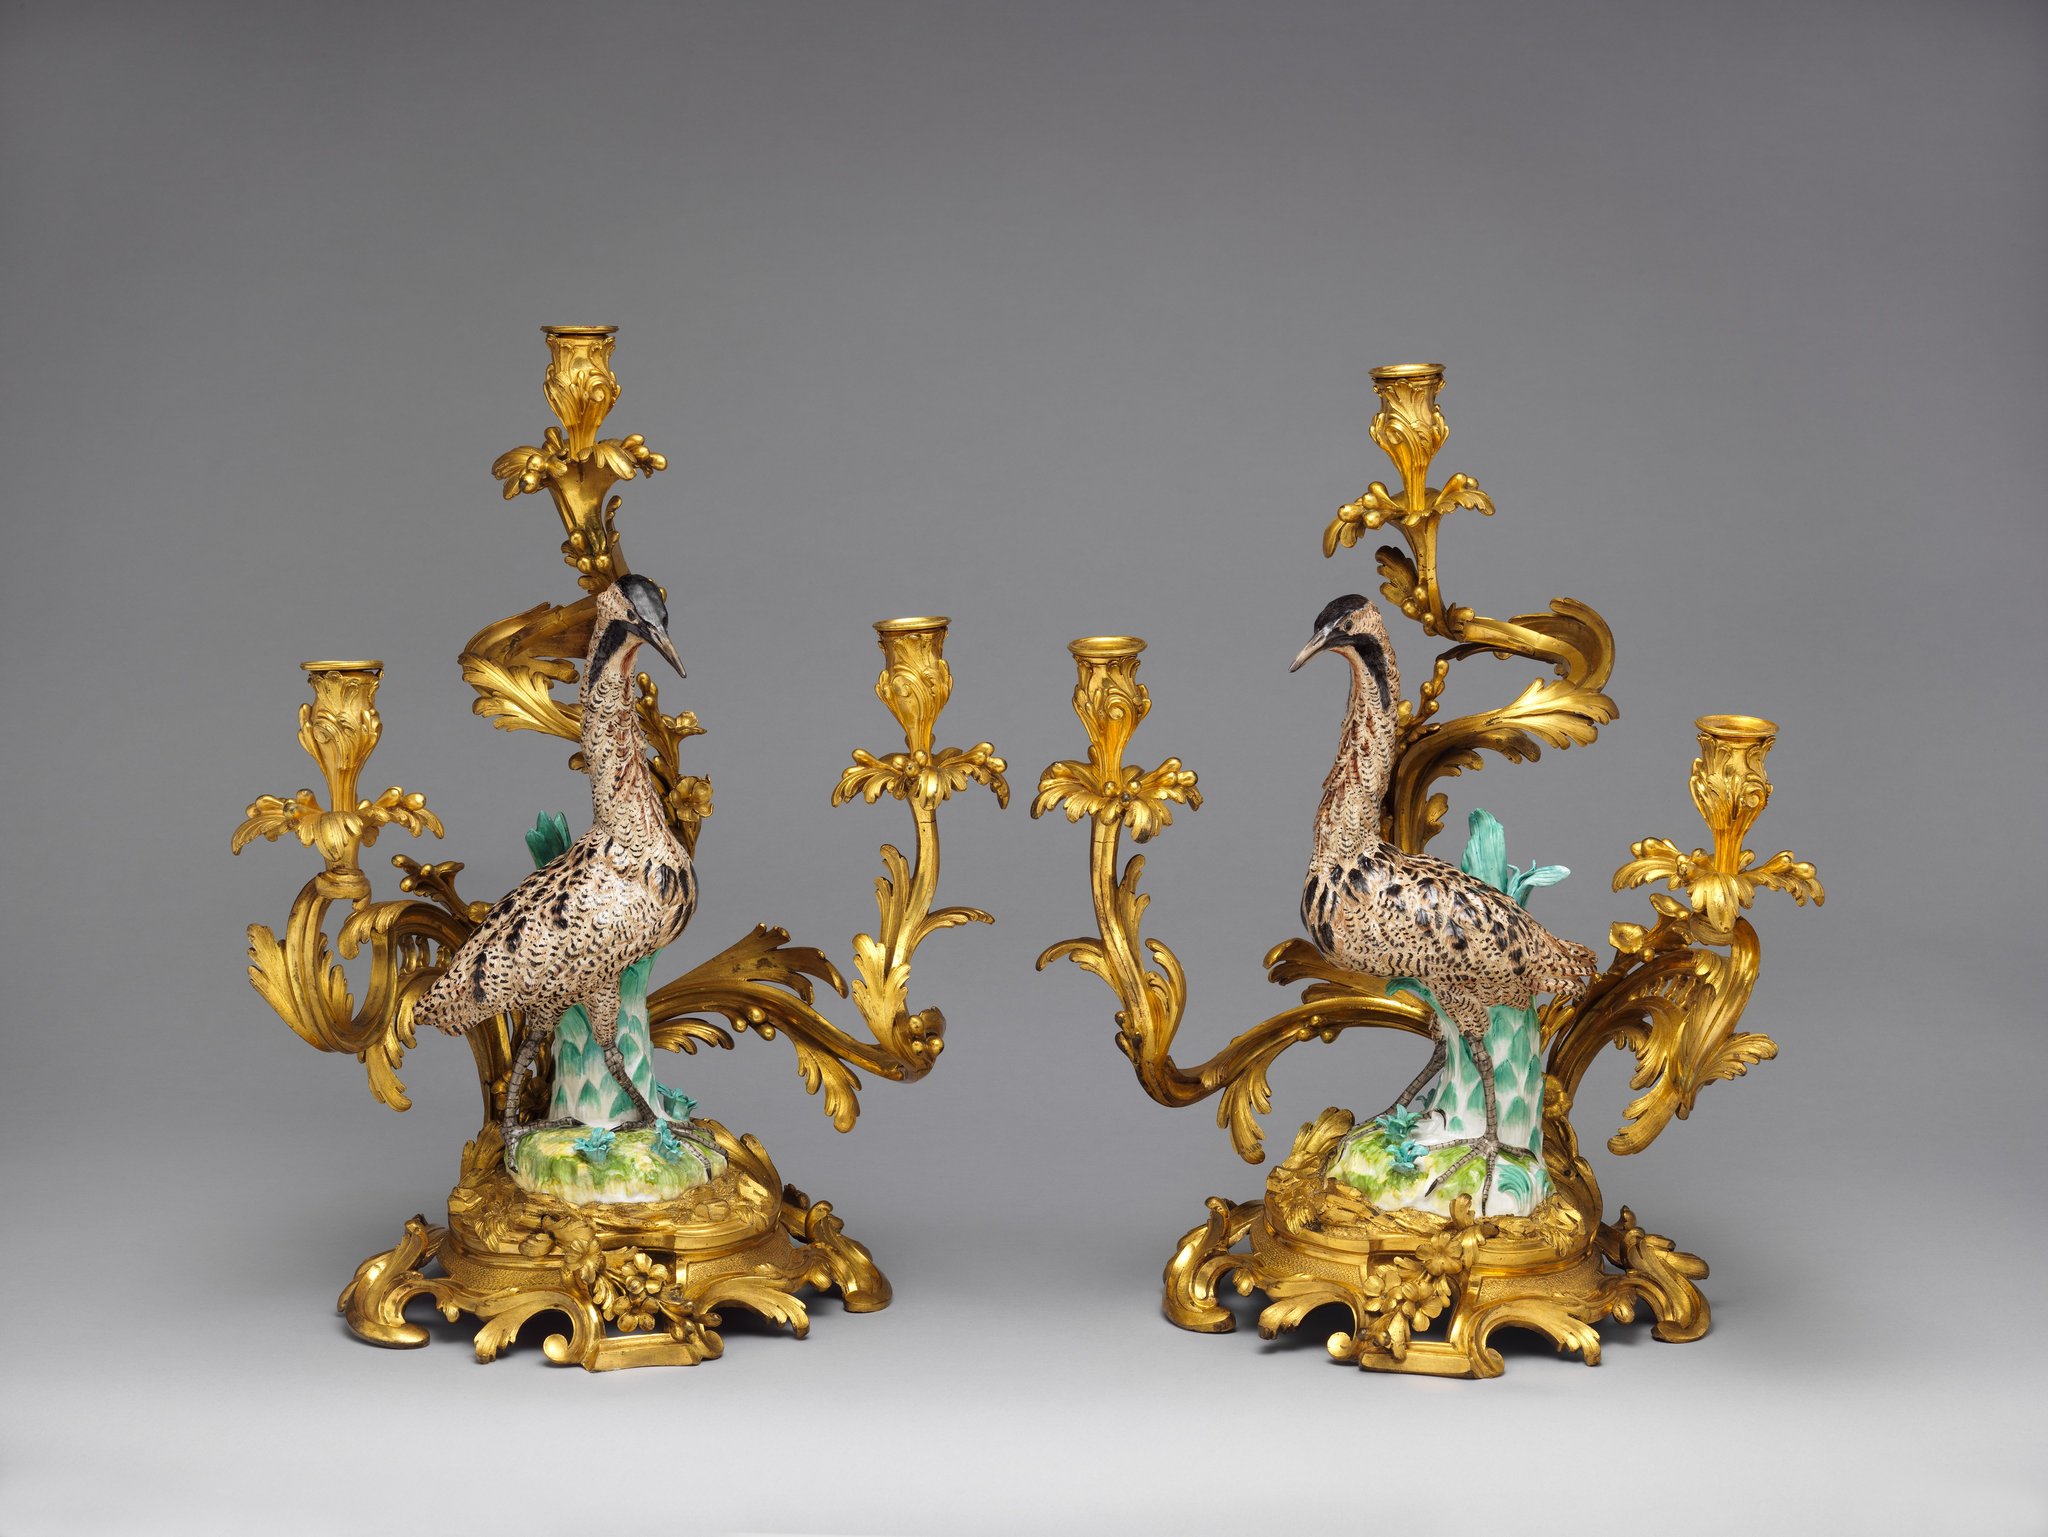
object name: candelabrum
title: Three-light candelabra (candélabra or girandole) (one of a pair)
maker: johann joachim kändler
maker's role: modeler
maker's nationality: german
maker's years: 1706-1775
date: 1750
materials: gilt bronze, hard paste porcelain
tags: birds